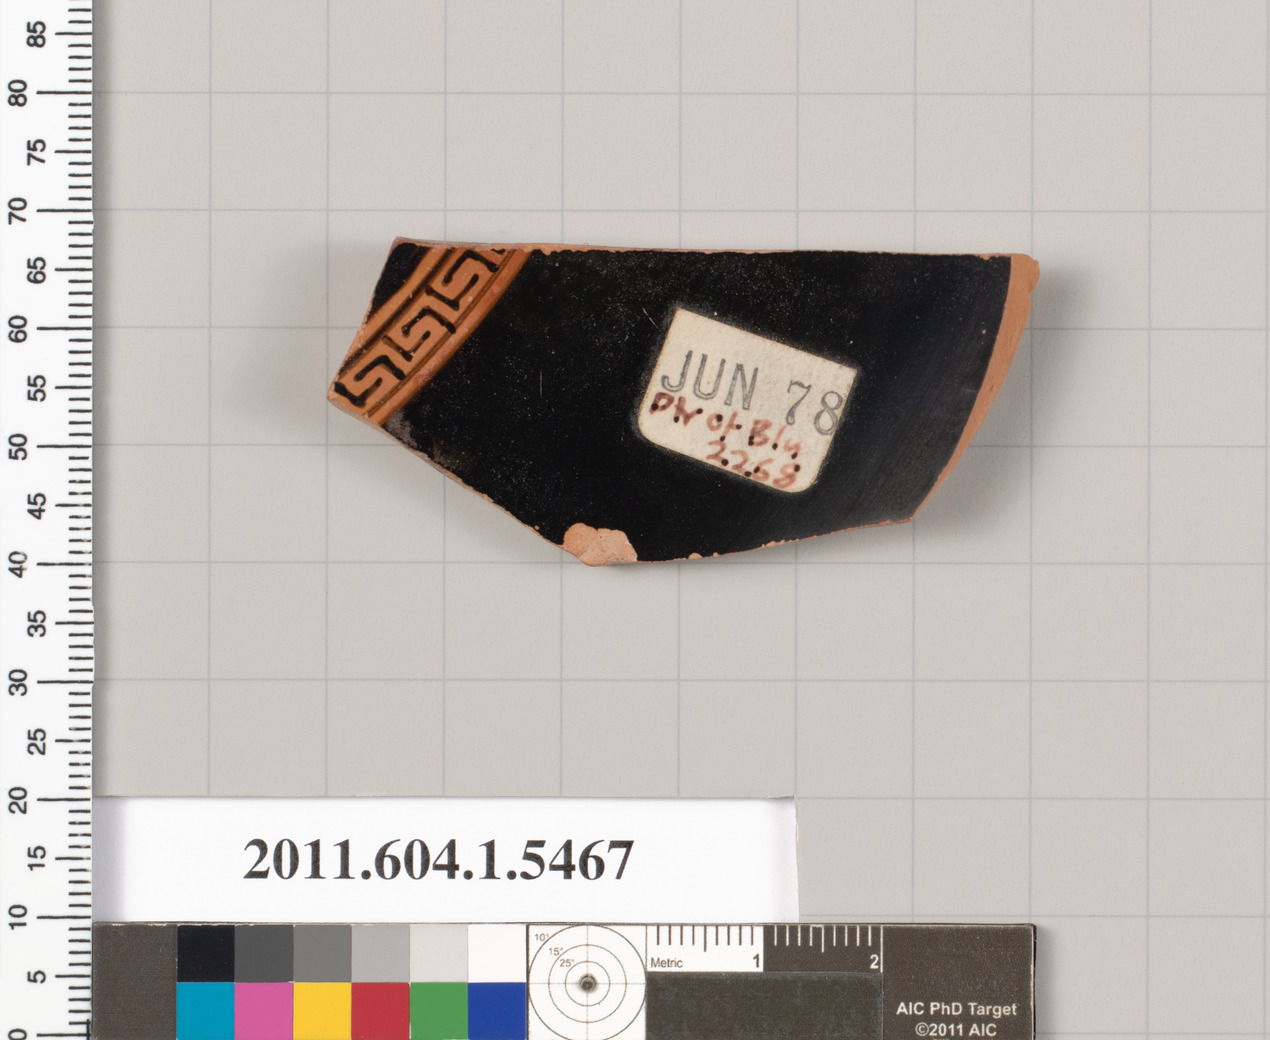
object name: kylix fragment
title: Terracotta fragment of a kylix (drinking cup)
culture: greek, attic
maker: painter of berlin 2268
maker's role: artist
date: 510-500 BCE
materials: terracotta